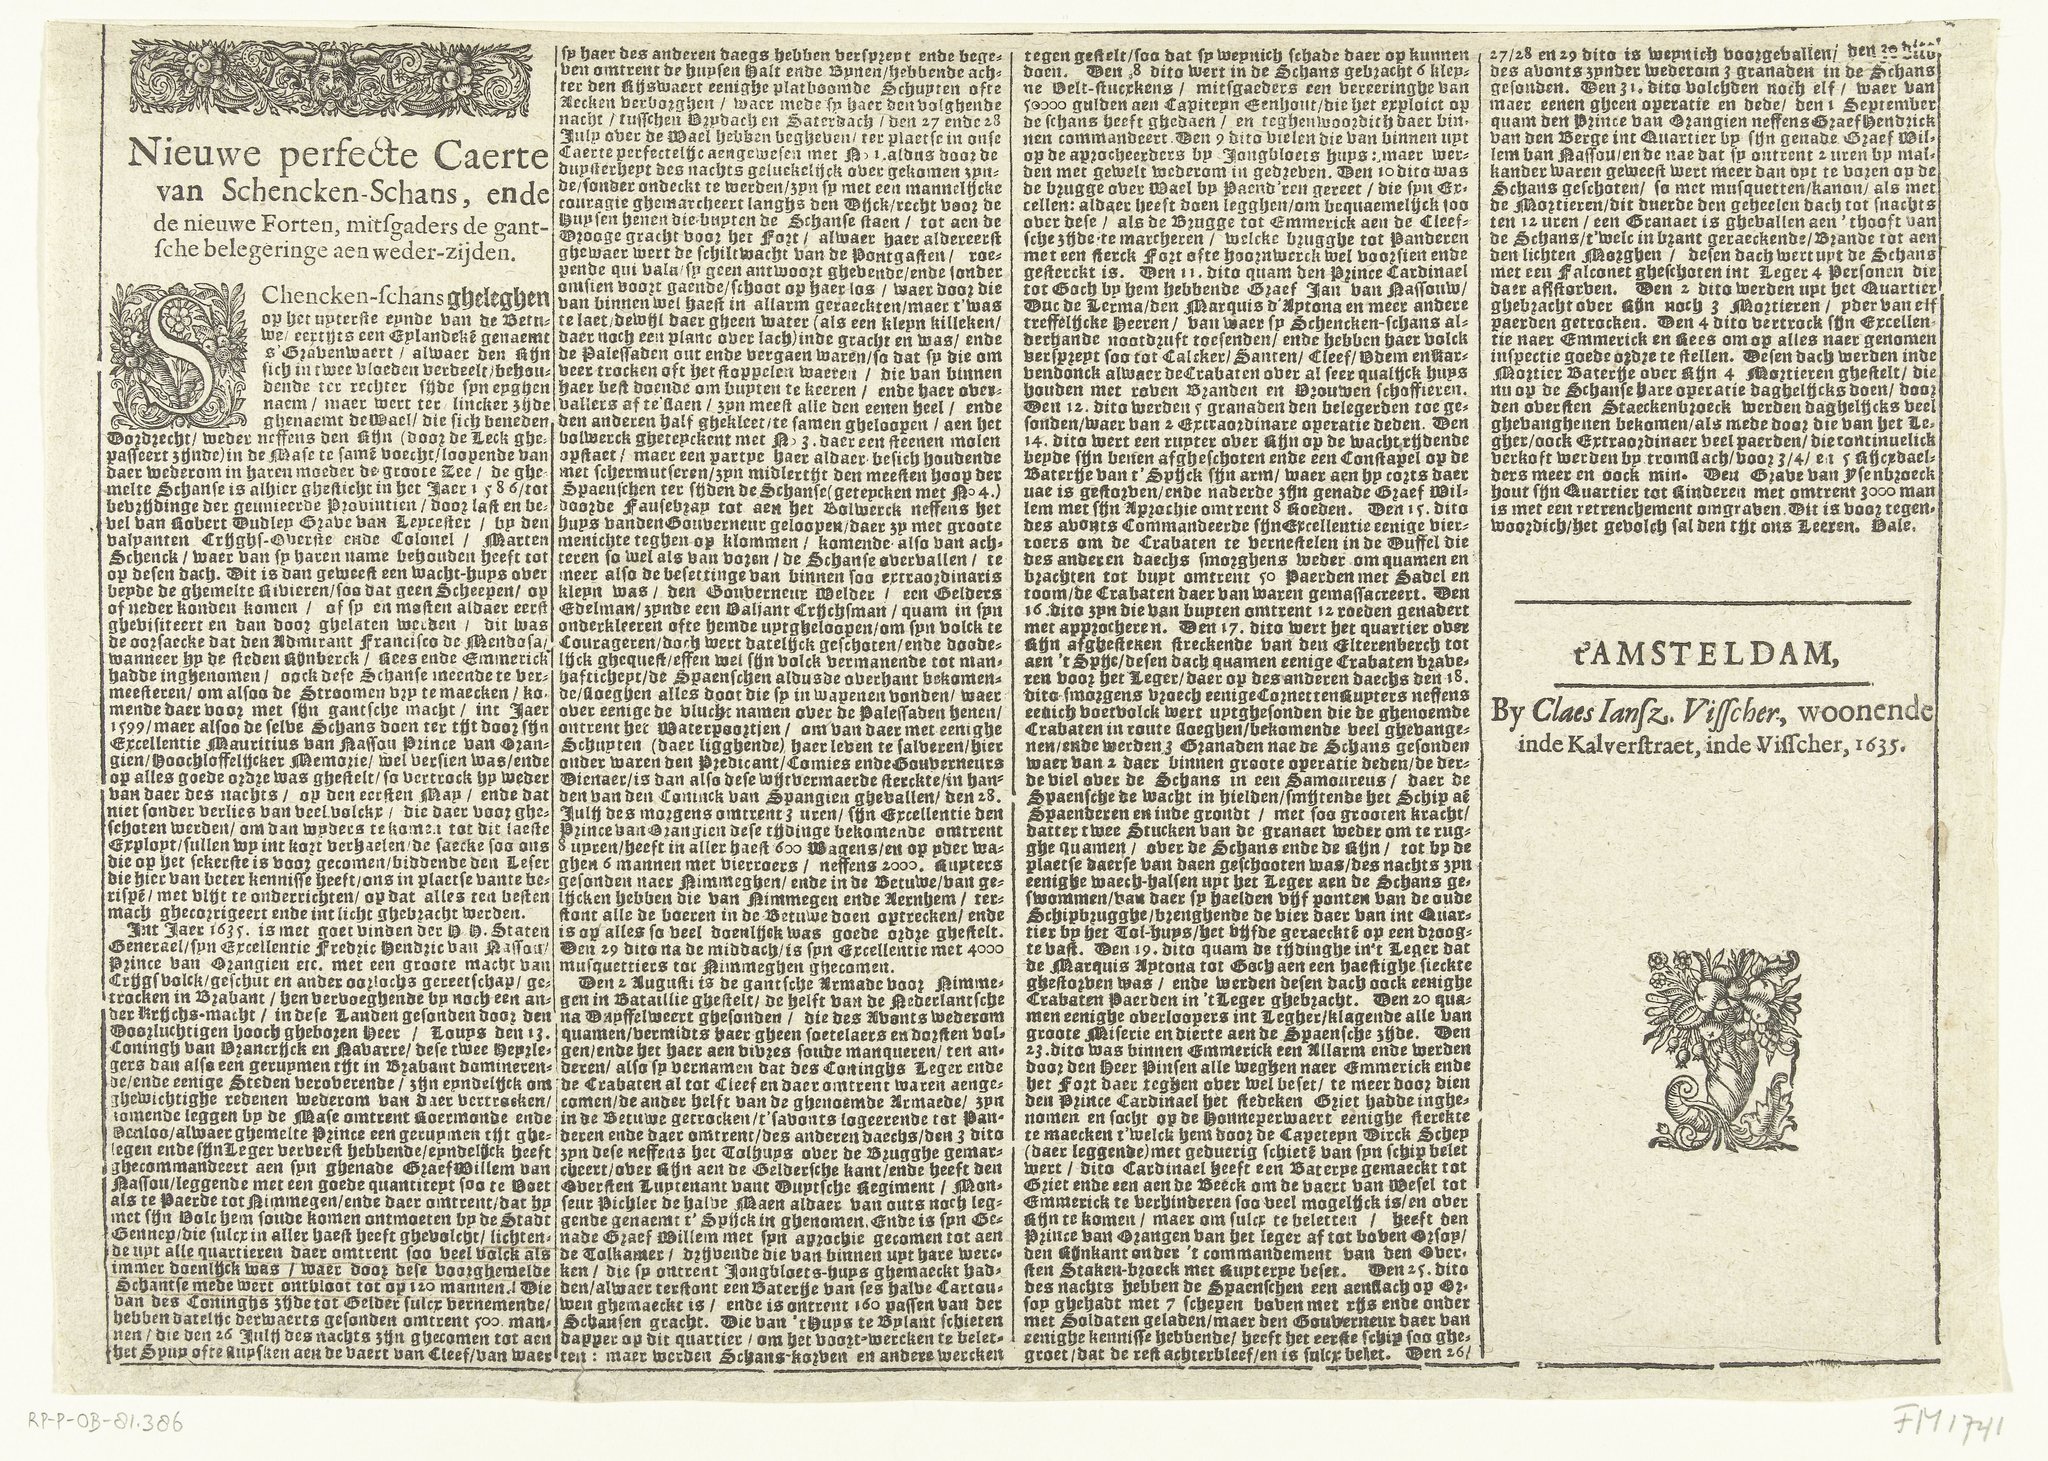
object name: print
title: Nieuwe perfecte Caerte van Schencken-Schans, ende de nieuwe Forten, mitsgaders de gantsche belegeringe aen weder-zijden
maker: claes jansz. visscher (ii)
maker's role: draughtsman, print maker, publisher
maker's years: 1586-1652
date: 1635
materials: paper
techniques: letterpress printing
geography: amsterdam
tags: delft, frederick henry (prince of orange)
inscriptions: date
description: Tekstblad gebruikt bij de kaart van het beleg van Schenckenschans door het Staatse leger onder Frederik Hendrik, vanaf 30 juli 1635. Laatst genoemde datum in de tekst is 4 september. Blad met vier kolommen tekst in het Nederlands, afgesloten met een fleuron onder het adres.